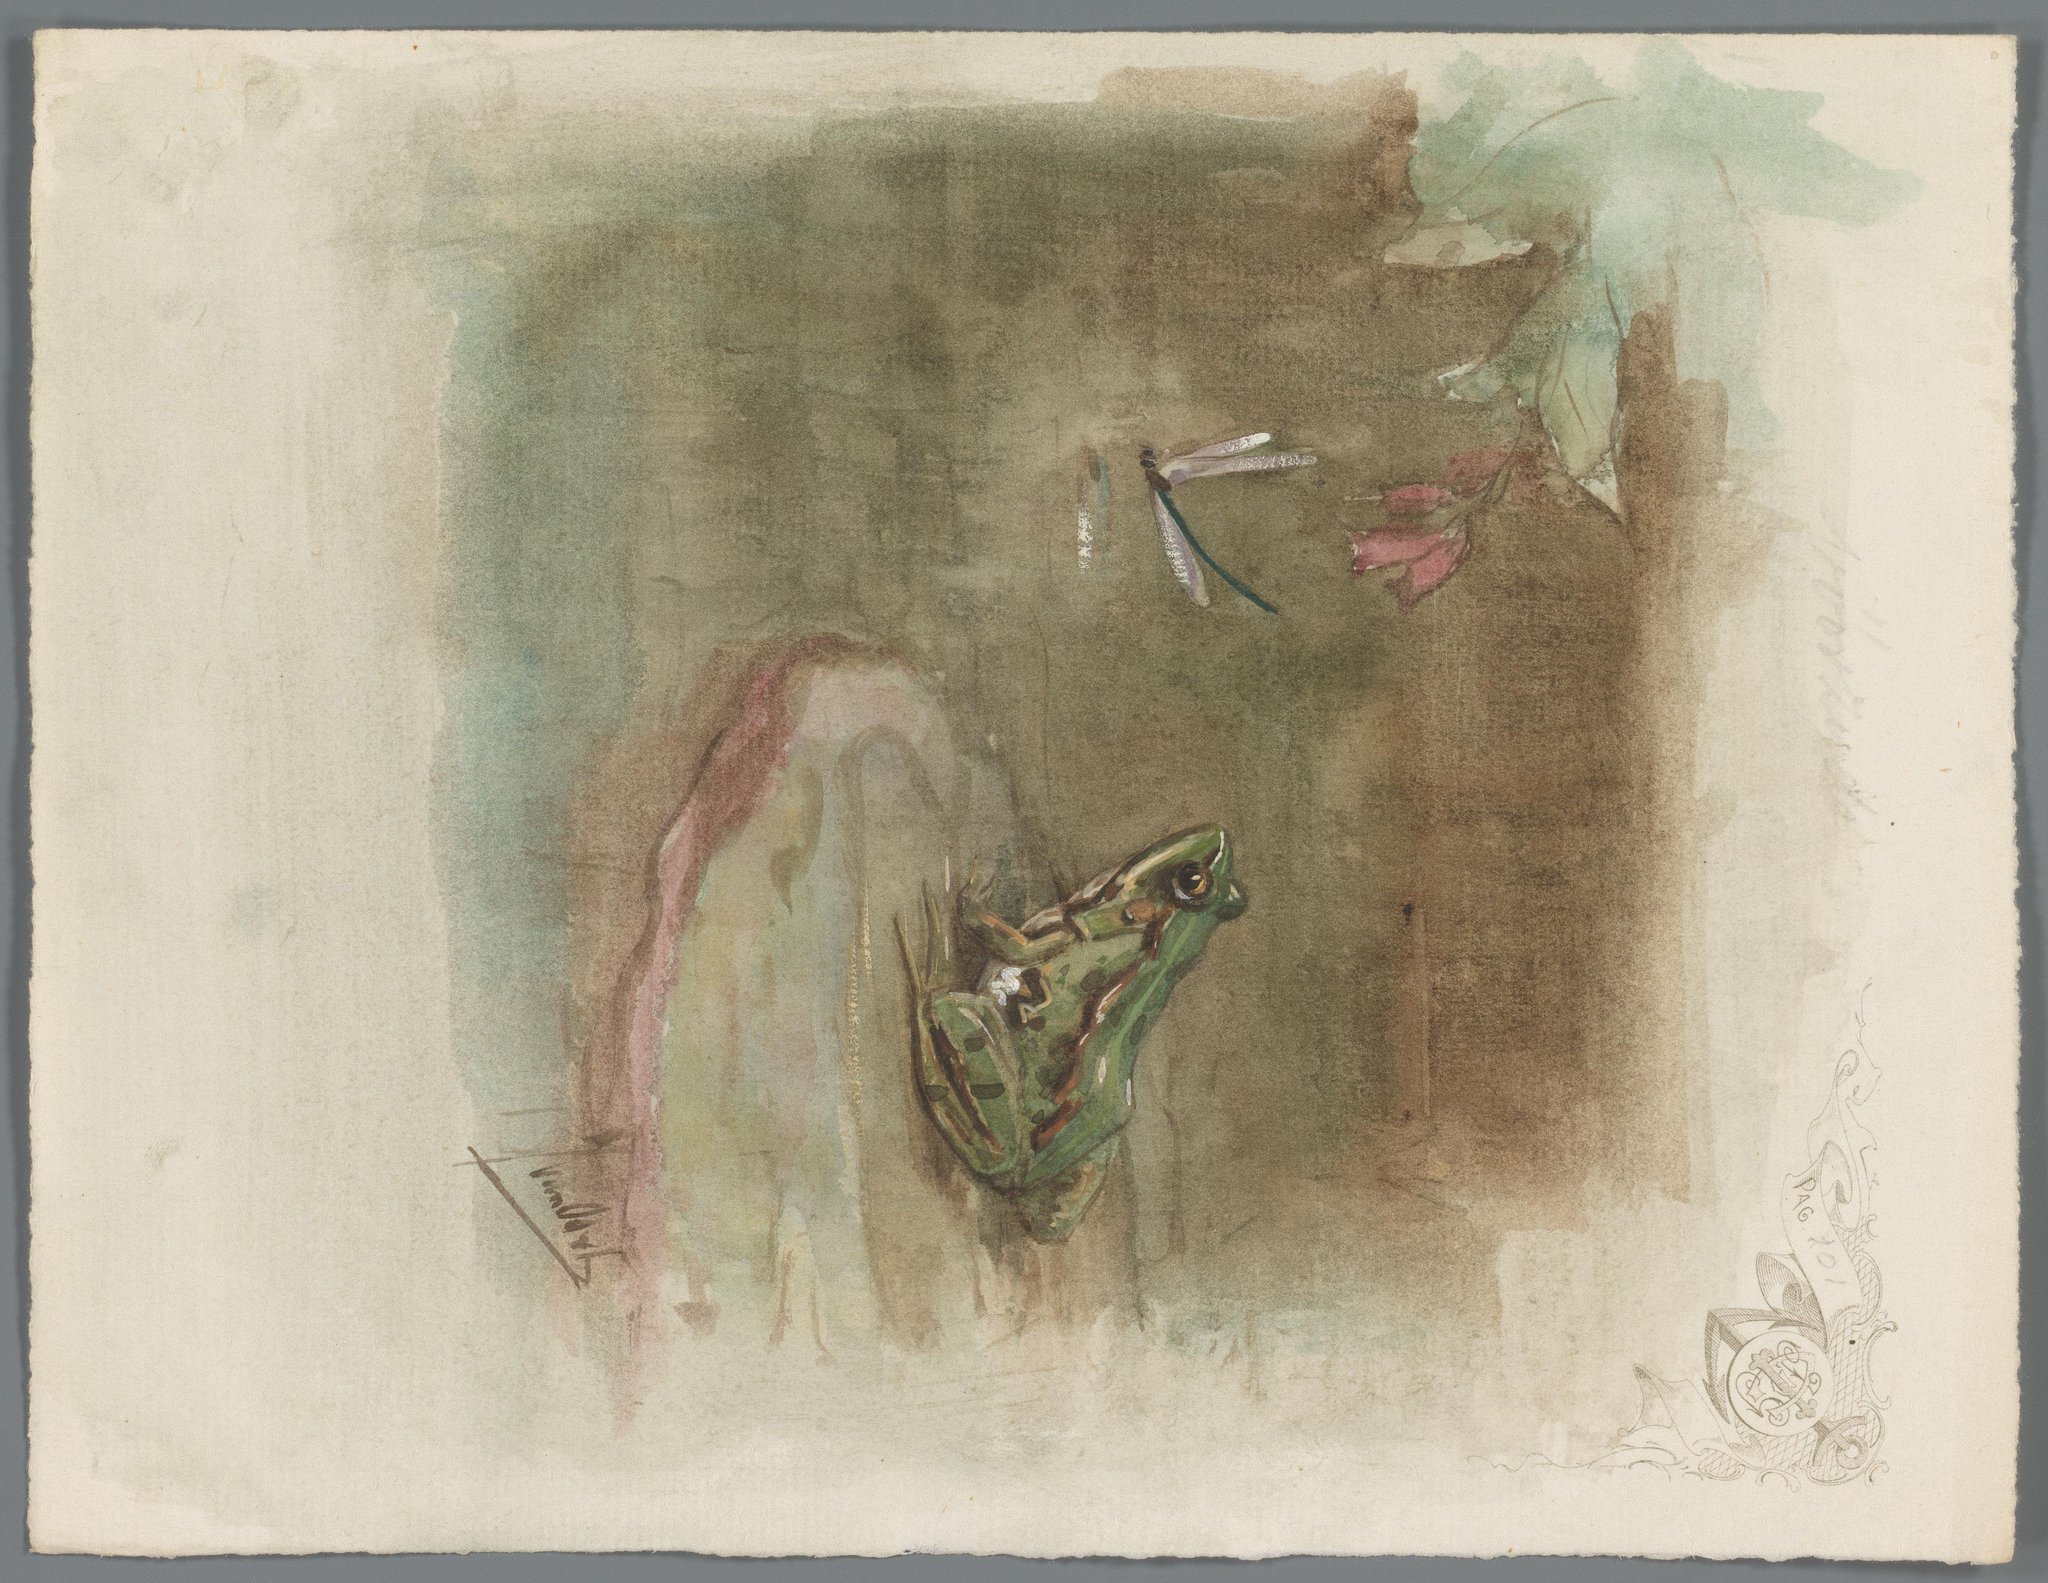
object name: drawing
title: Kikker en libelle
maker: jan van oort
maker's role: draughtsman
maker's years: 1867-1938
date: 1894-1919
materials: paint, paper, watercolor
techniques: brush, lithograph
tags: tailless amphibians: frog, insects: dragon-fly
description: Tekening op een blad met gepersonaliseerde decoratie in de vorm van een anker met monogram, met ruimte voor een paginanummer.